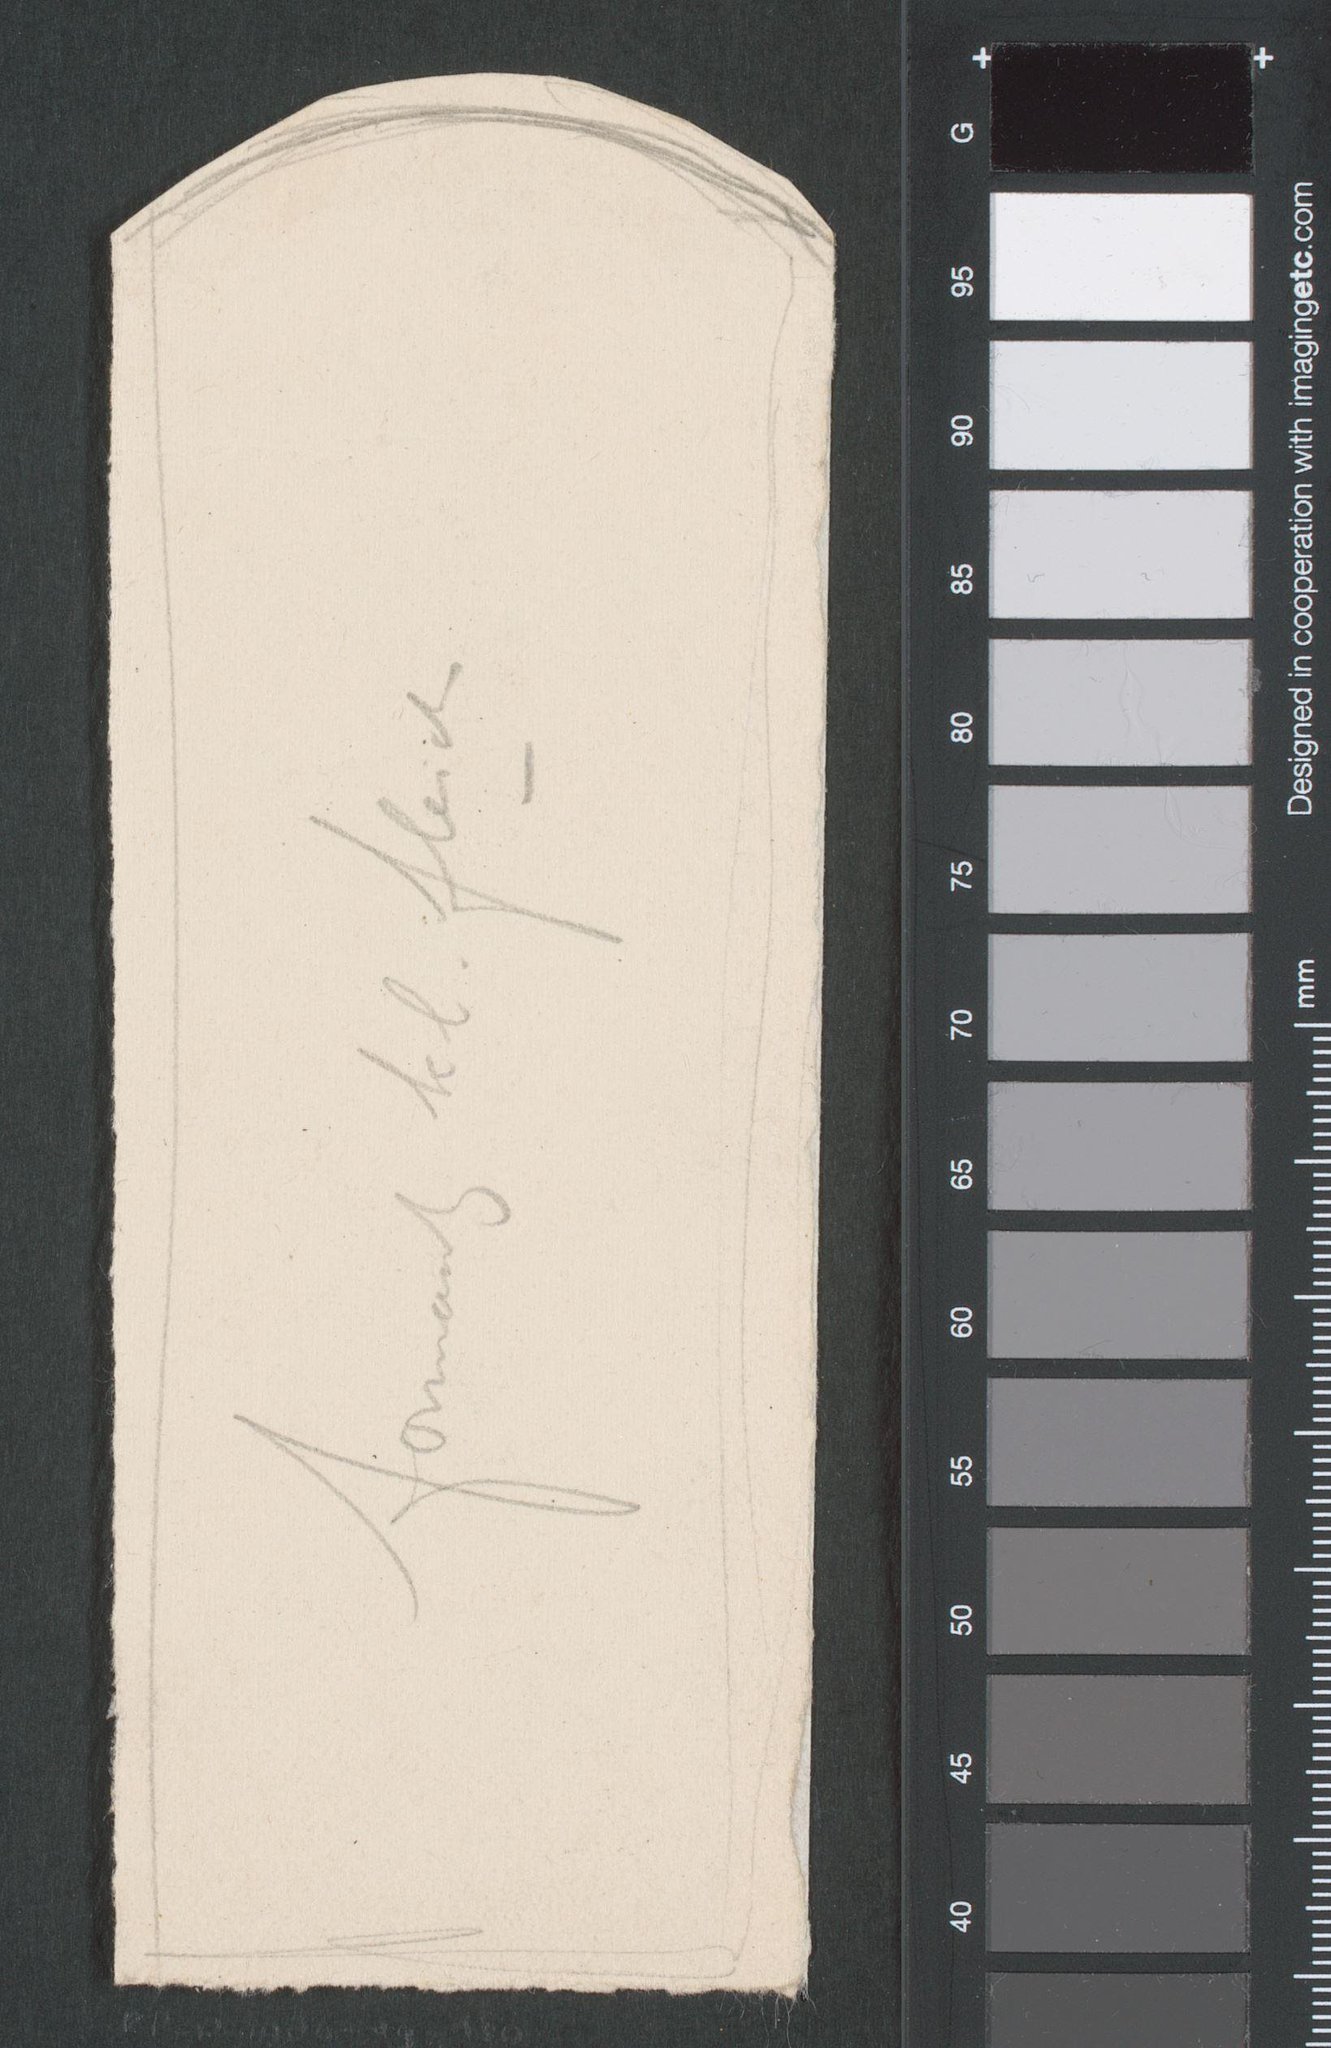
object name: design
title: Ontwerp voor een apothekersetiket voor levertraanemulsie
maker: reinier willem petrus de vries (1874-1953)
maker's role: draughtsman, print maker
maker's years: 1874-1953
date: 1884-1952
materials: paper, pencil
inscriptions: collector's mark: ‘R:MVS.’, annotation: ‘formaat kl . flesch’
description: Ontwerp voor de vorm en het formaat van het etiket voor een kleine fles.